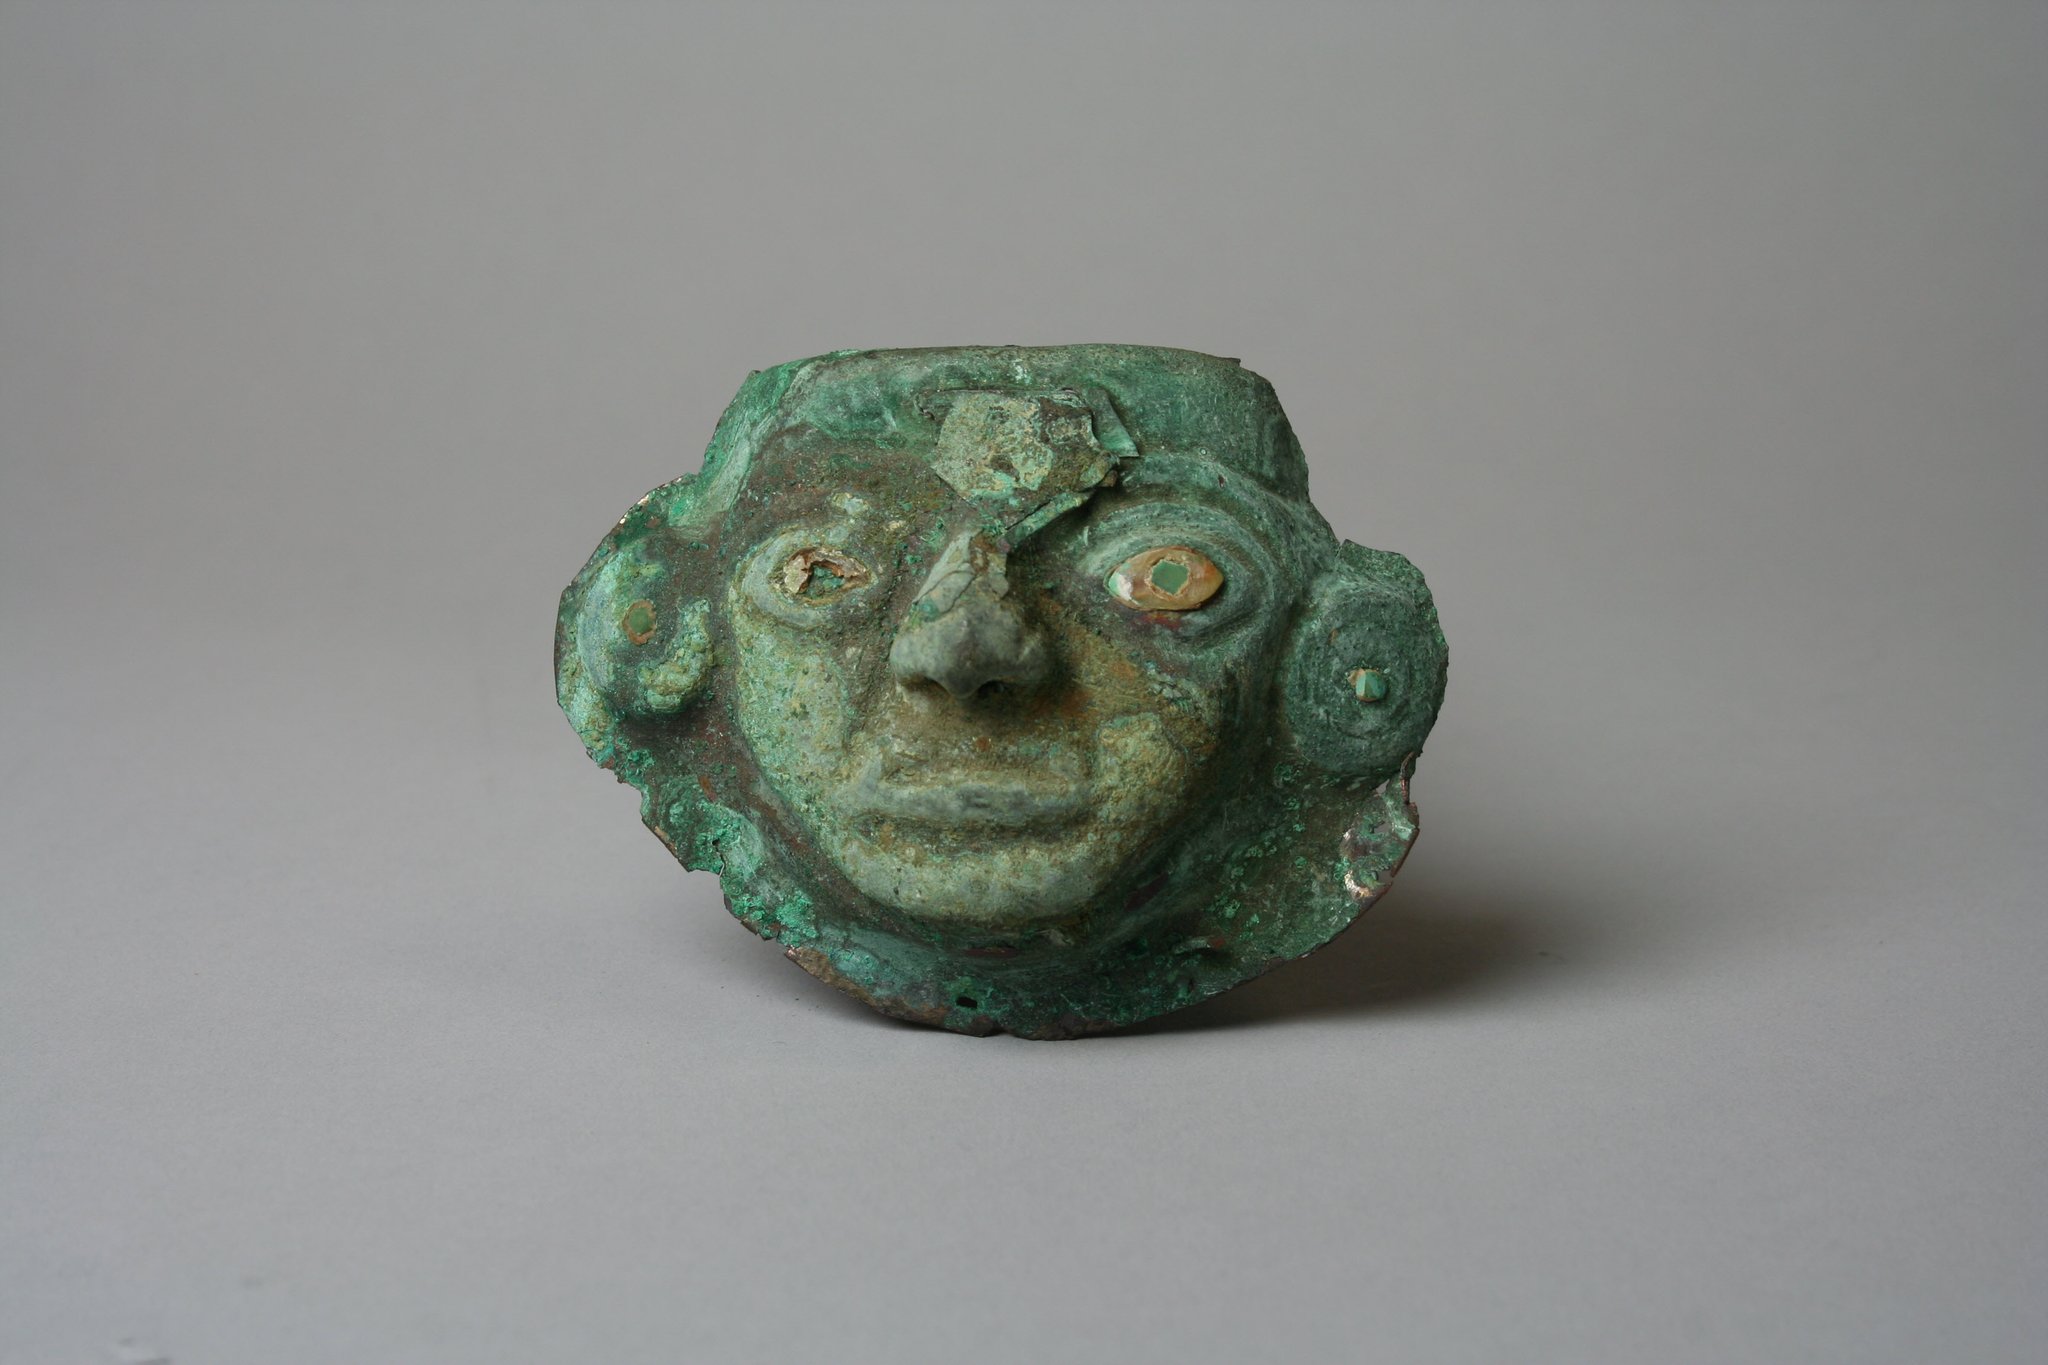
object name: ornament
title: Face Mask Ornament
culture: moche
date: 501-700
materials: gilt copper, shell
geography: peru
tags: masks